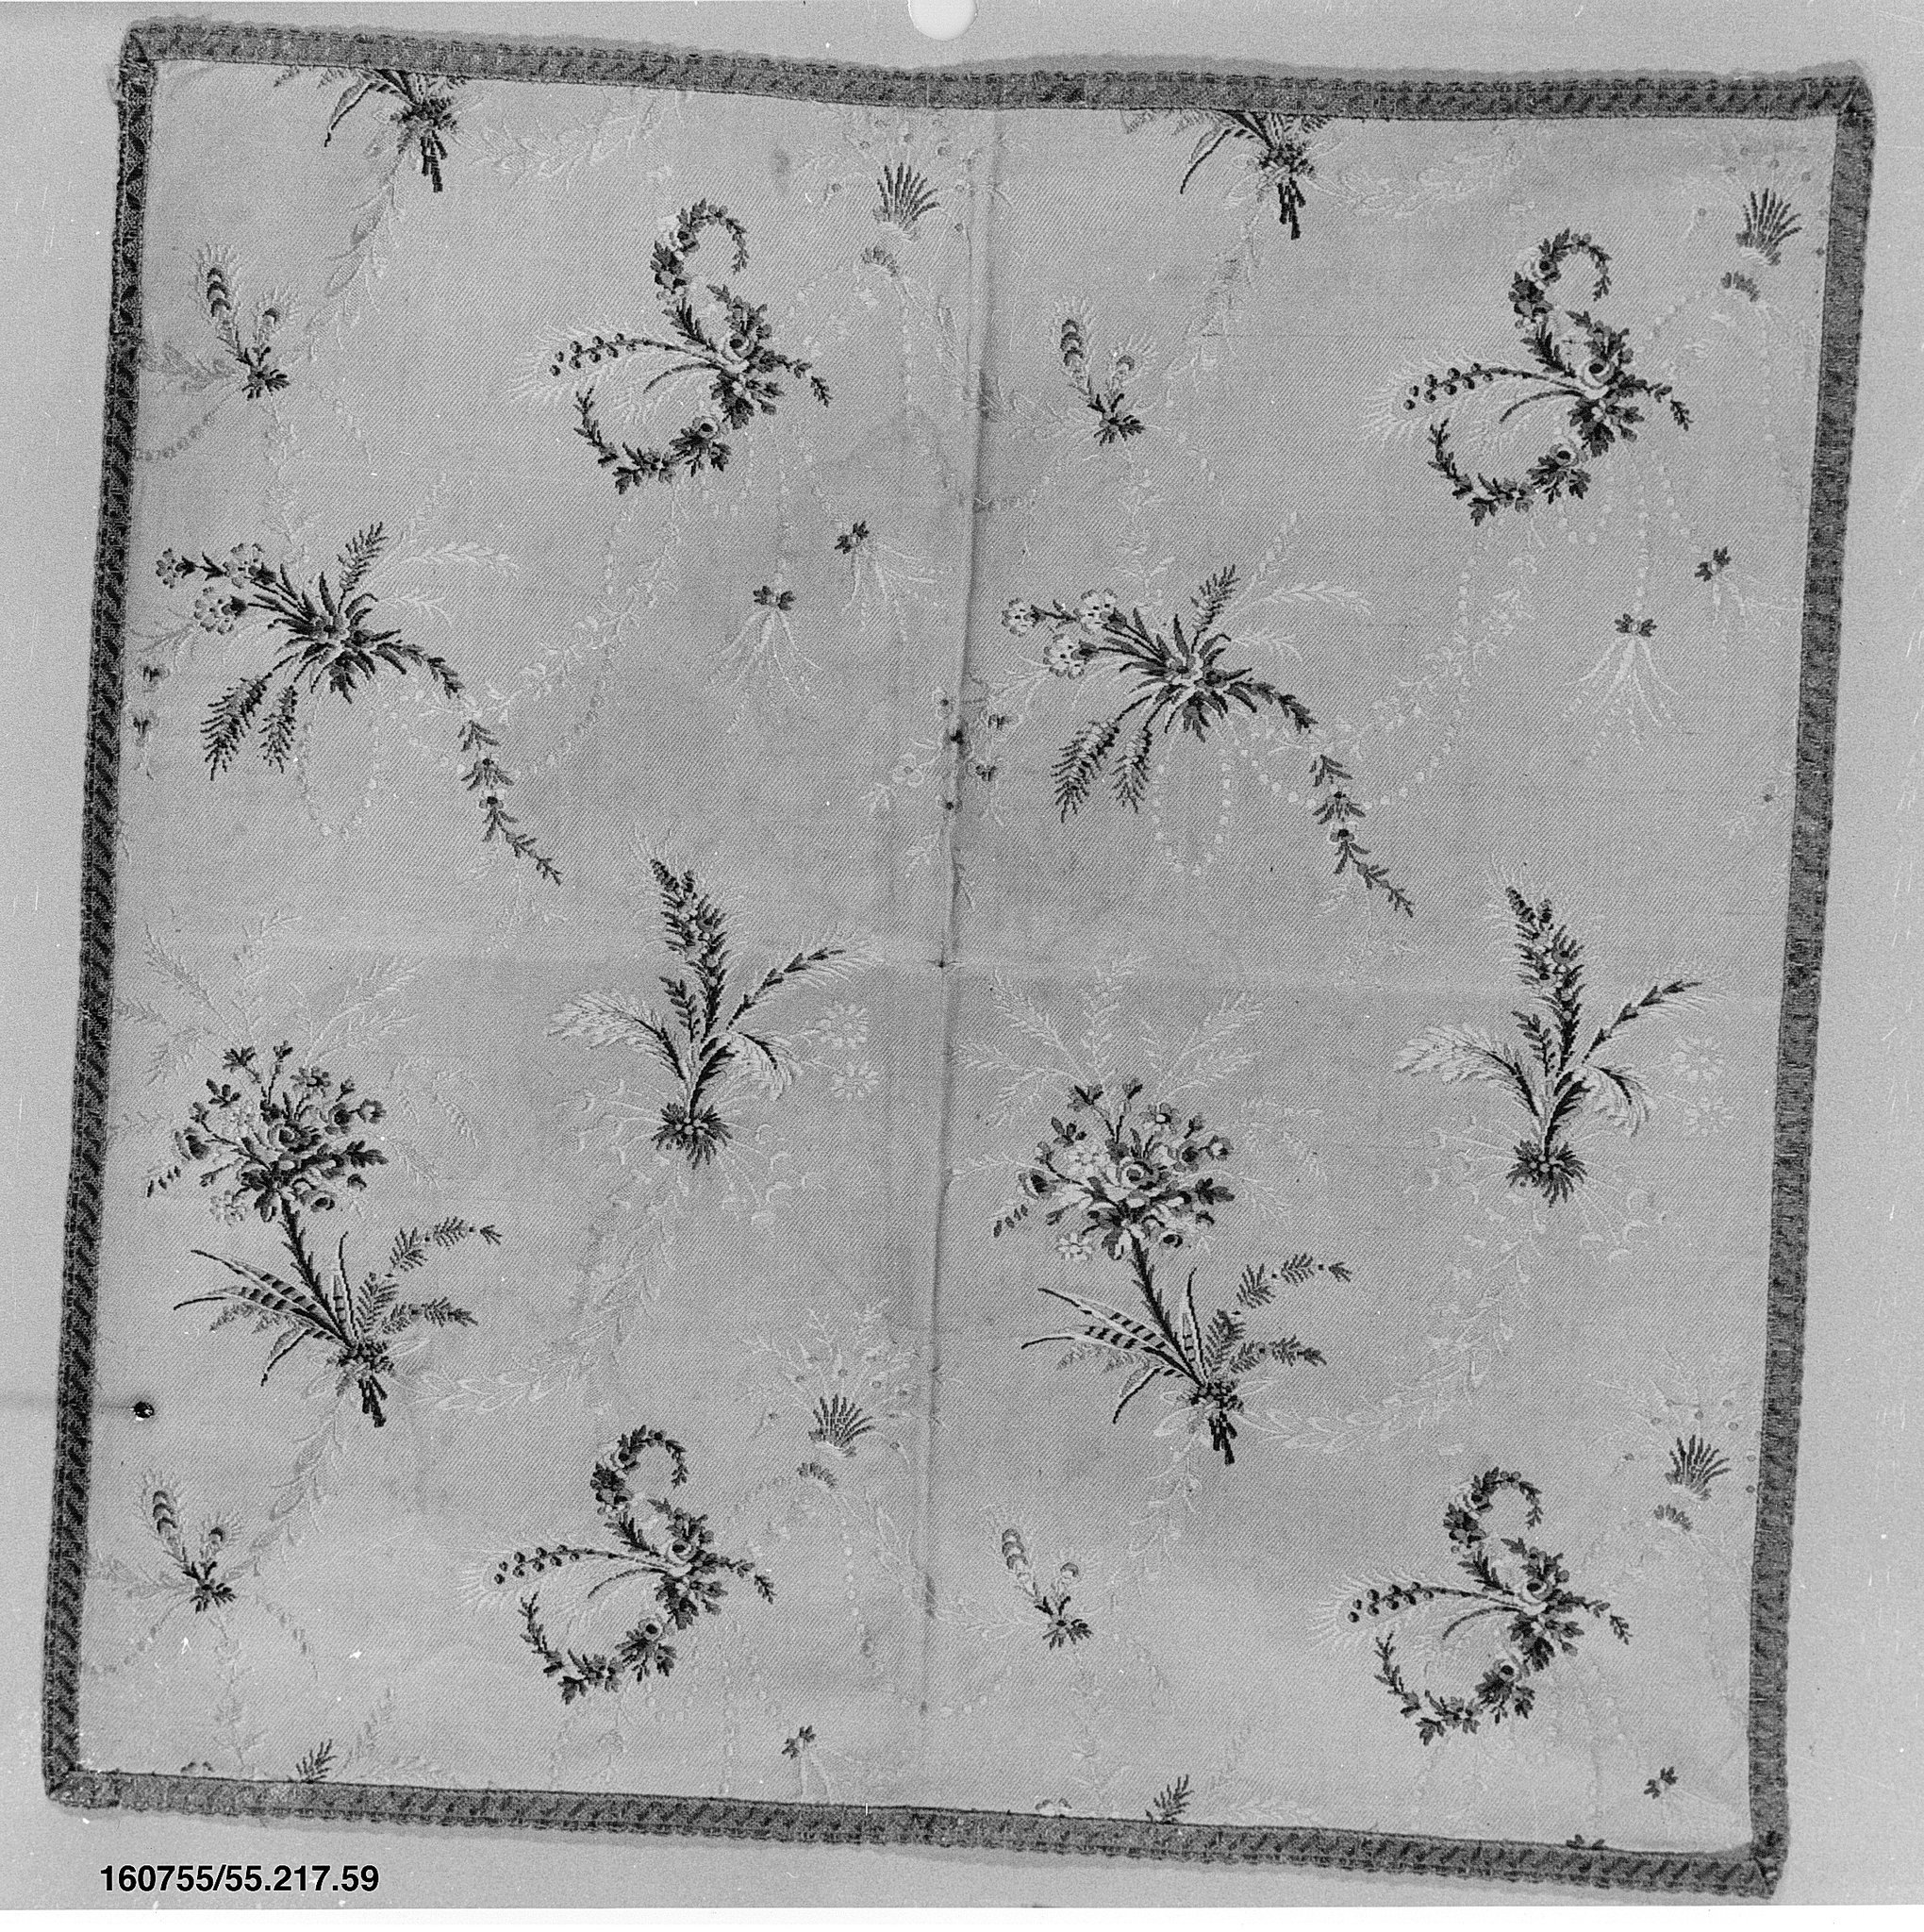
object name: piece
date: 1760-1770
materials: silk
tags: flowers,leaves